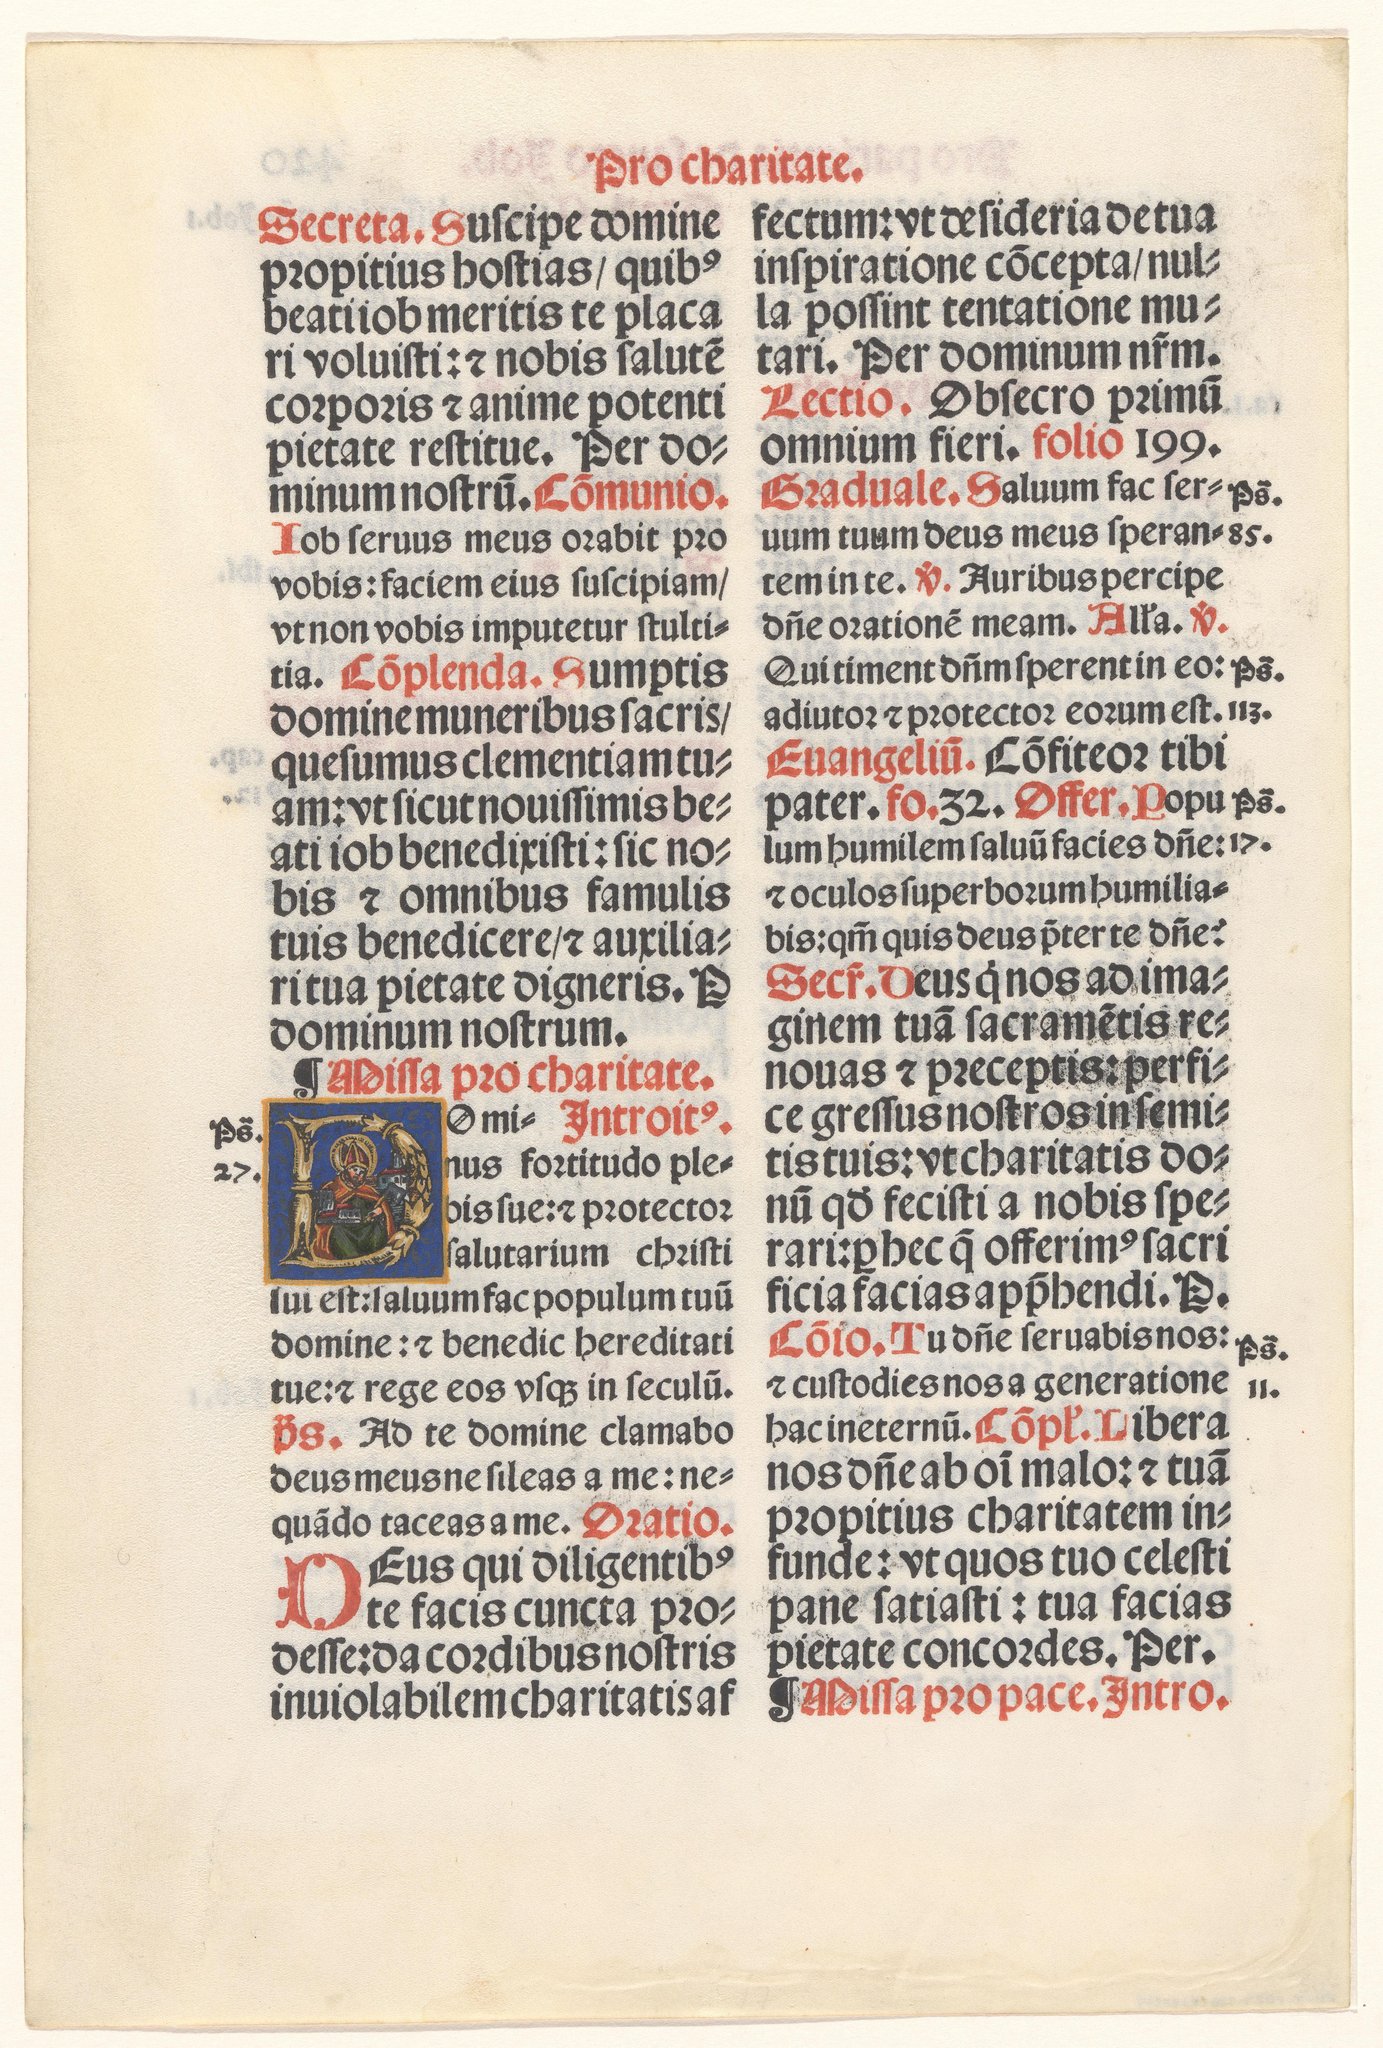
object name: page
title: Blad uit een getijdenboek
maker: Anonymous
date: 1450-1499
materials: paint, ink, paper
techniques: brush, letterpress printing, pen